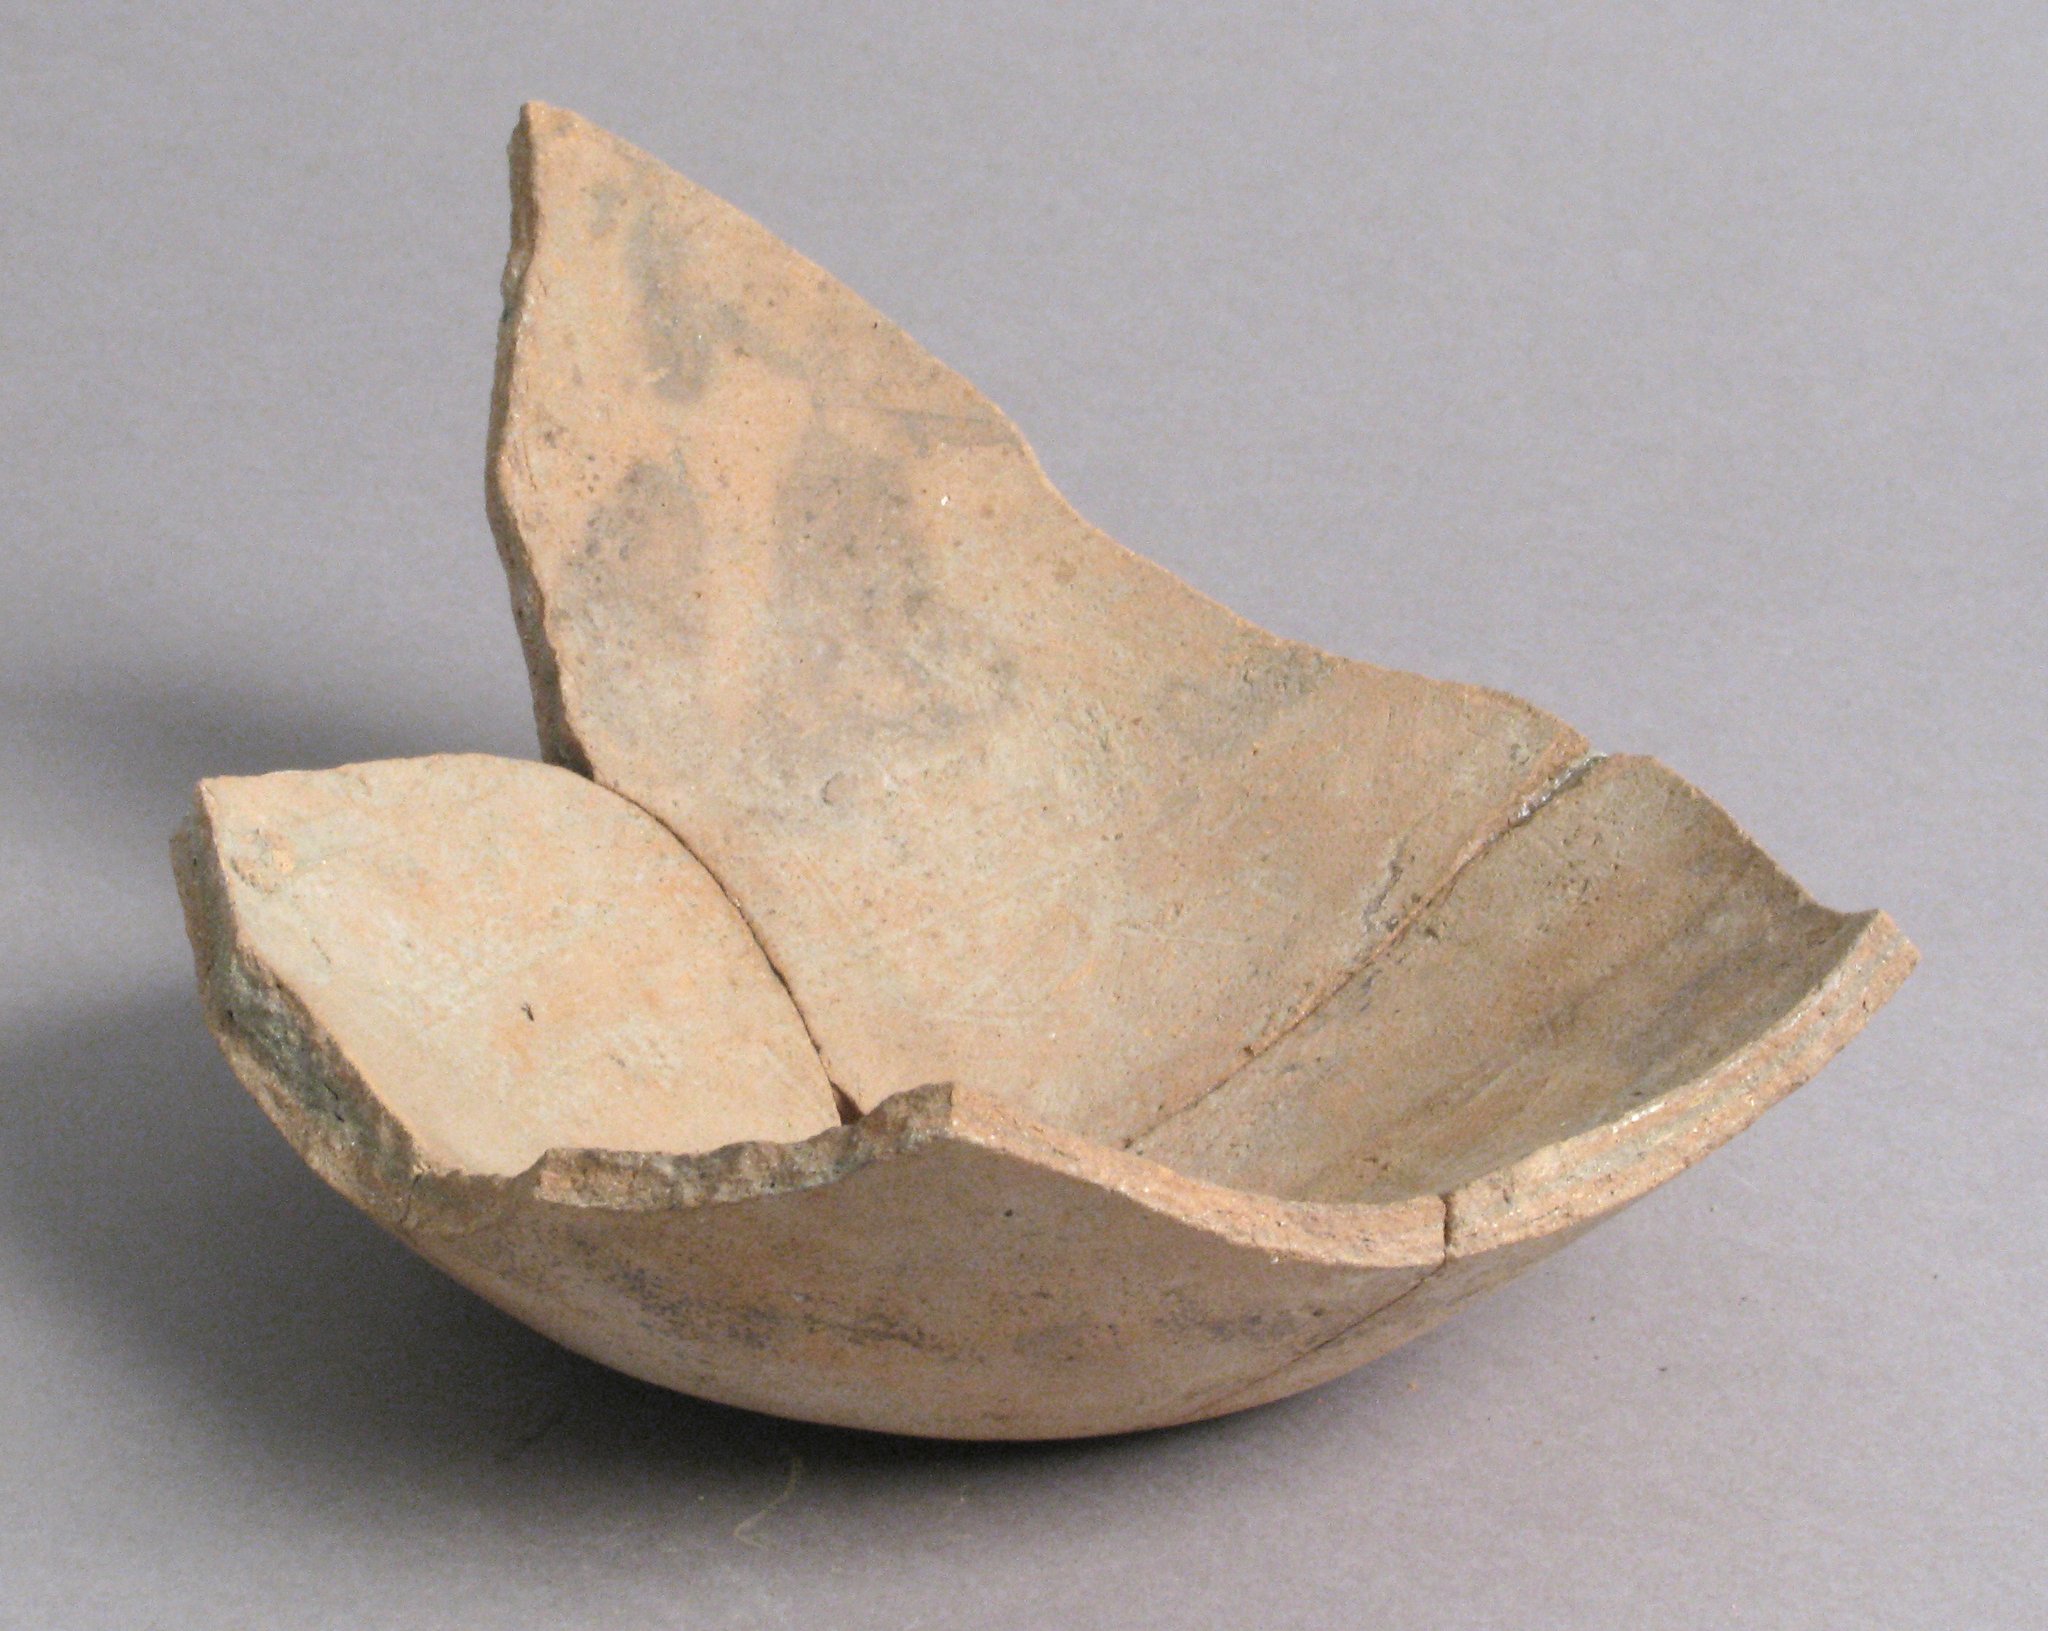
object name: fragment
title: Pot Fragment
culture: coptic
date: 301-700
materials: earthenware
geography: egypt